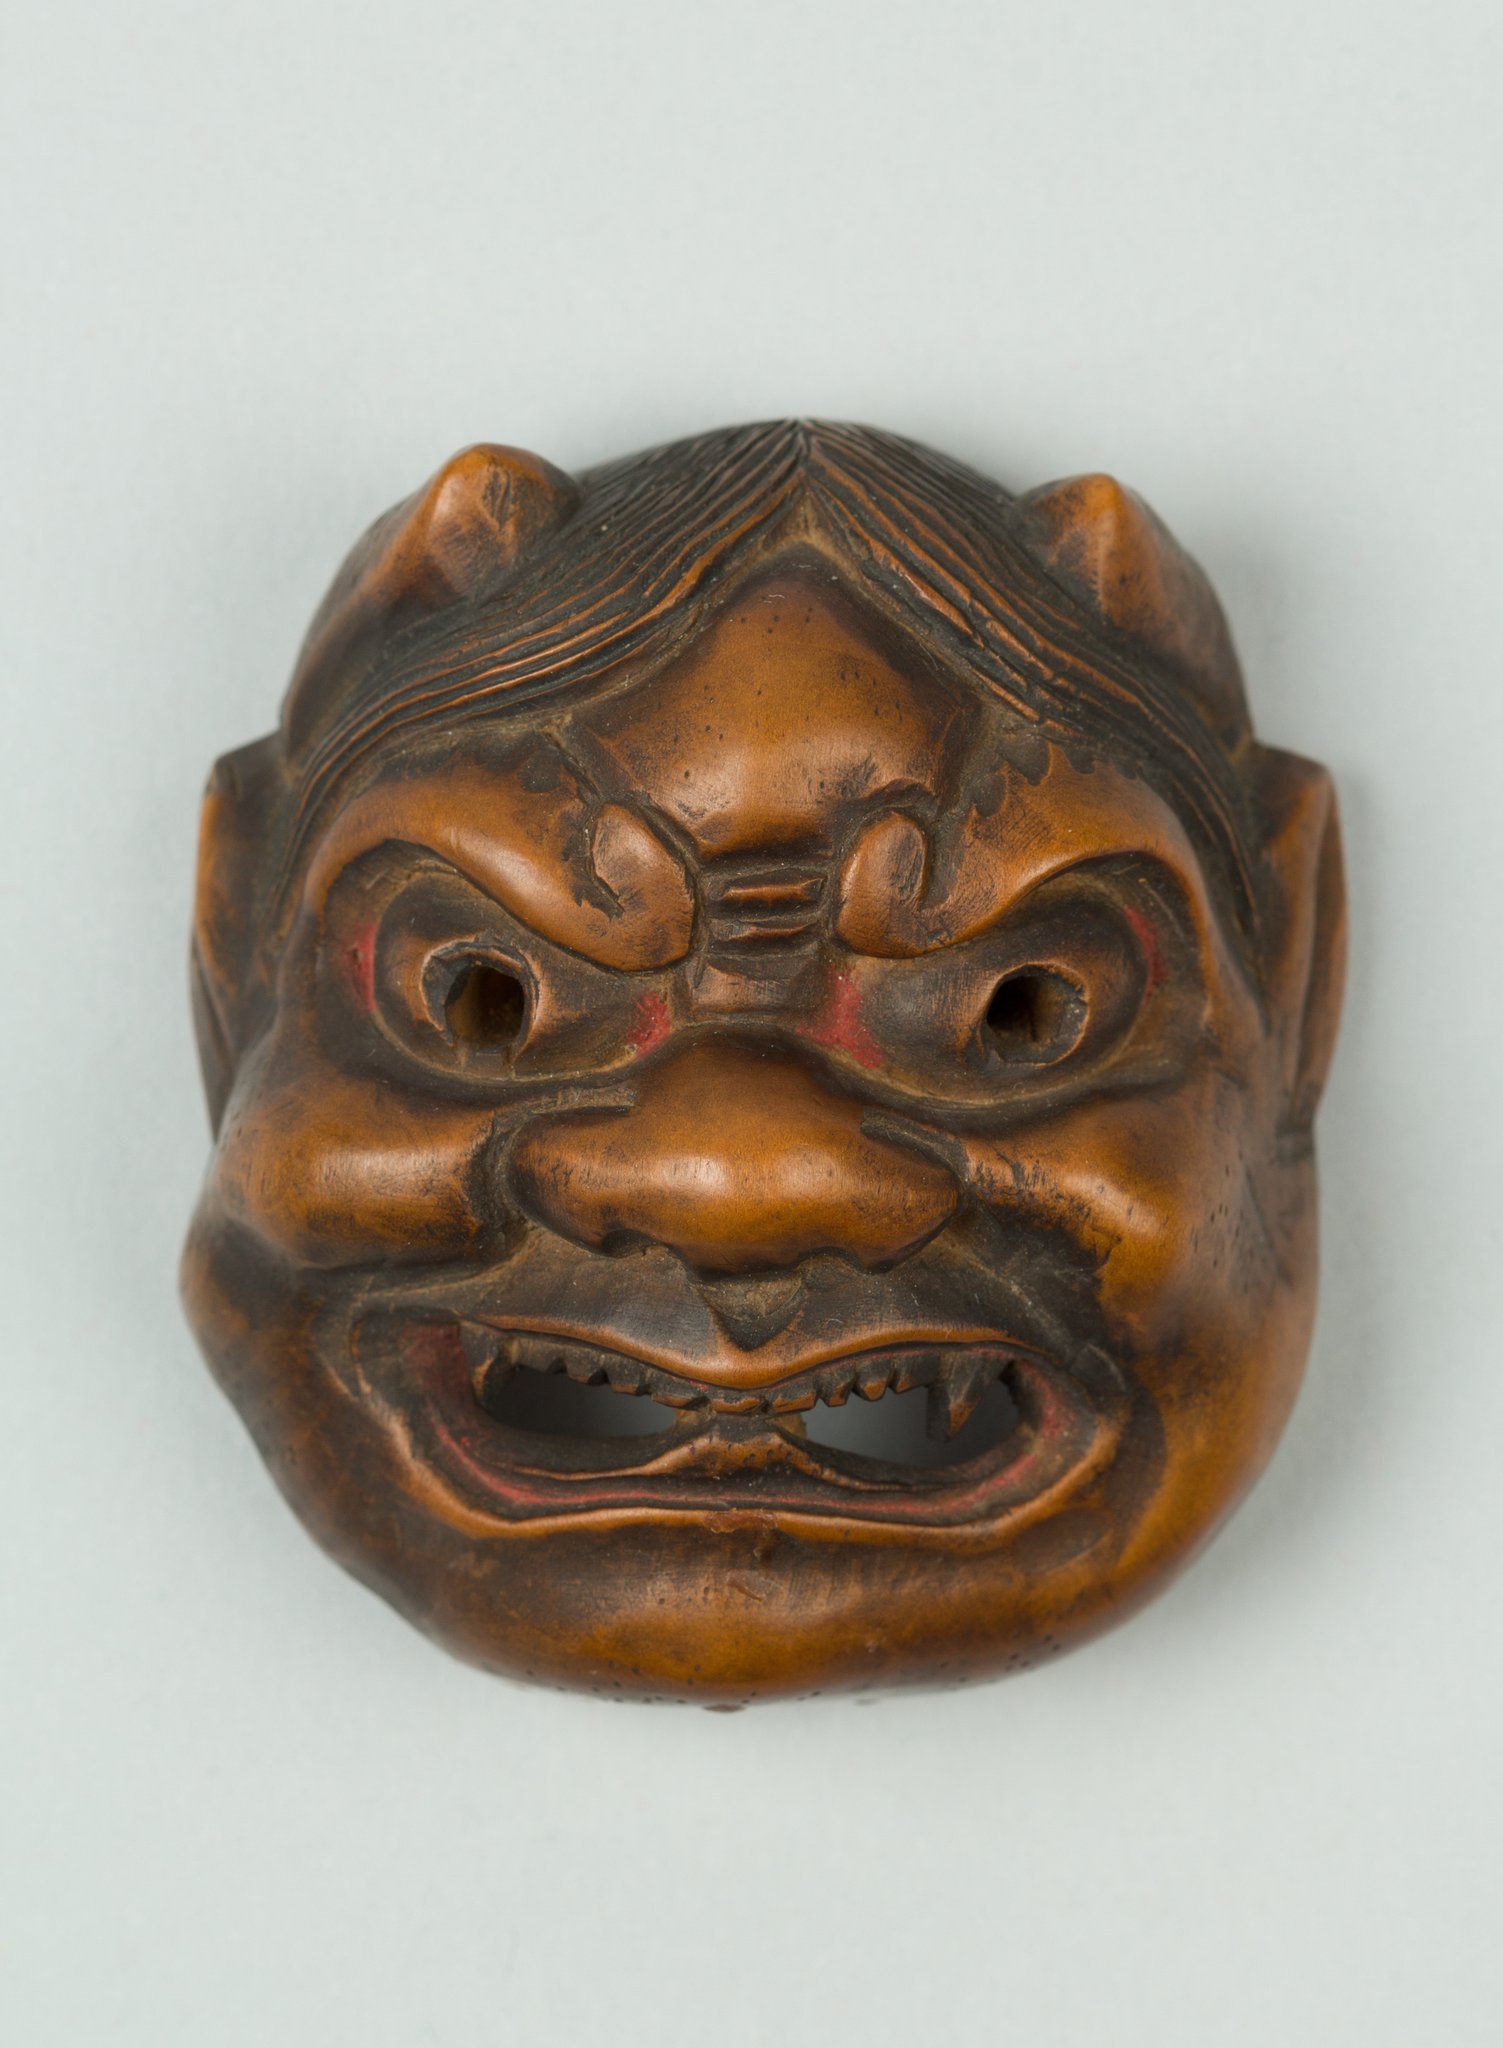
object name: netsuke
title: Netsuke of Noh Mask; Demon (?)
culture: japanese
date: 1801-1900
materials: wood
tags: masks,demons